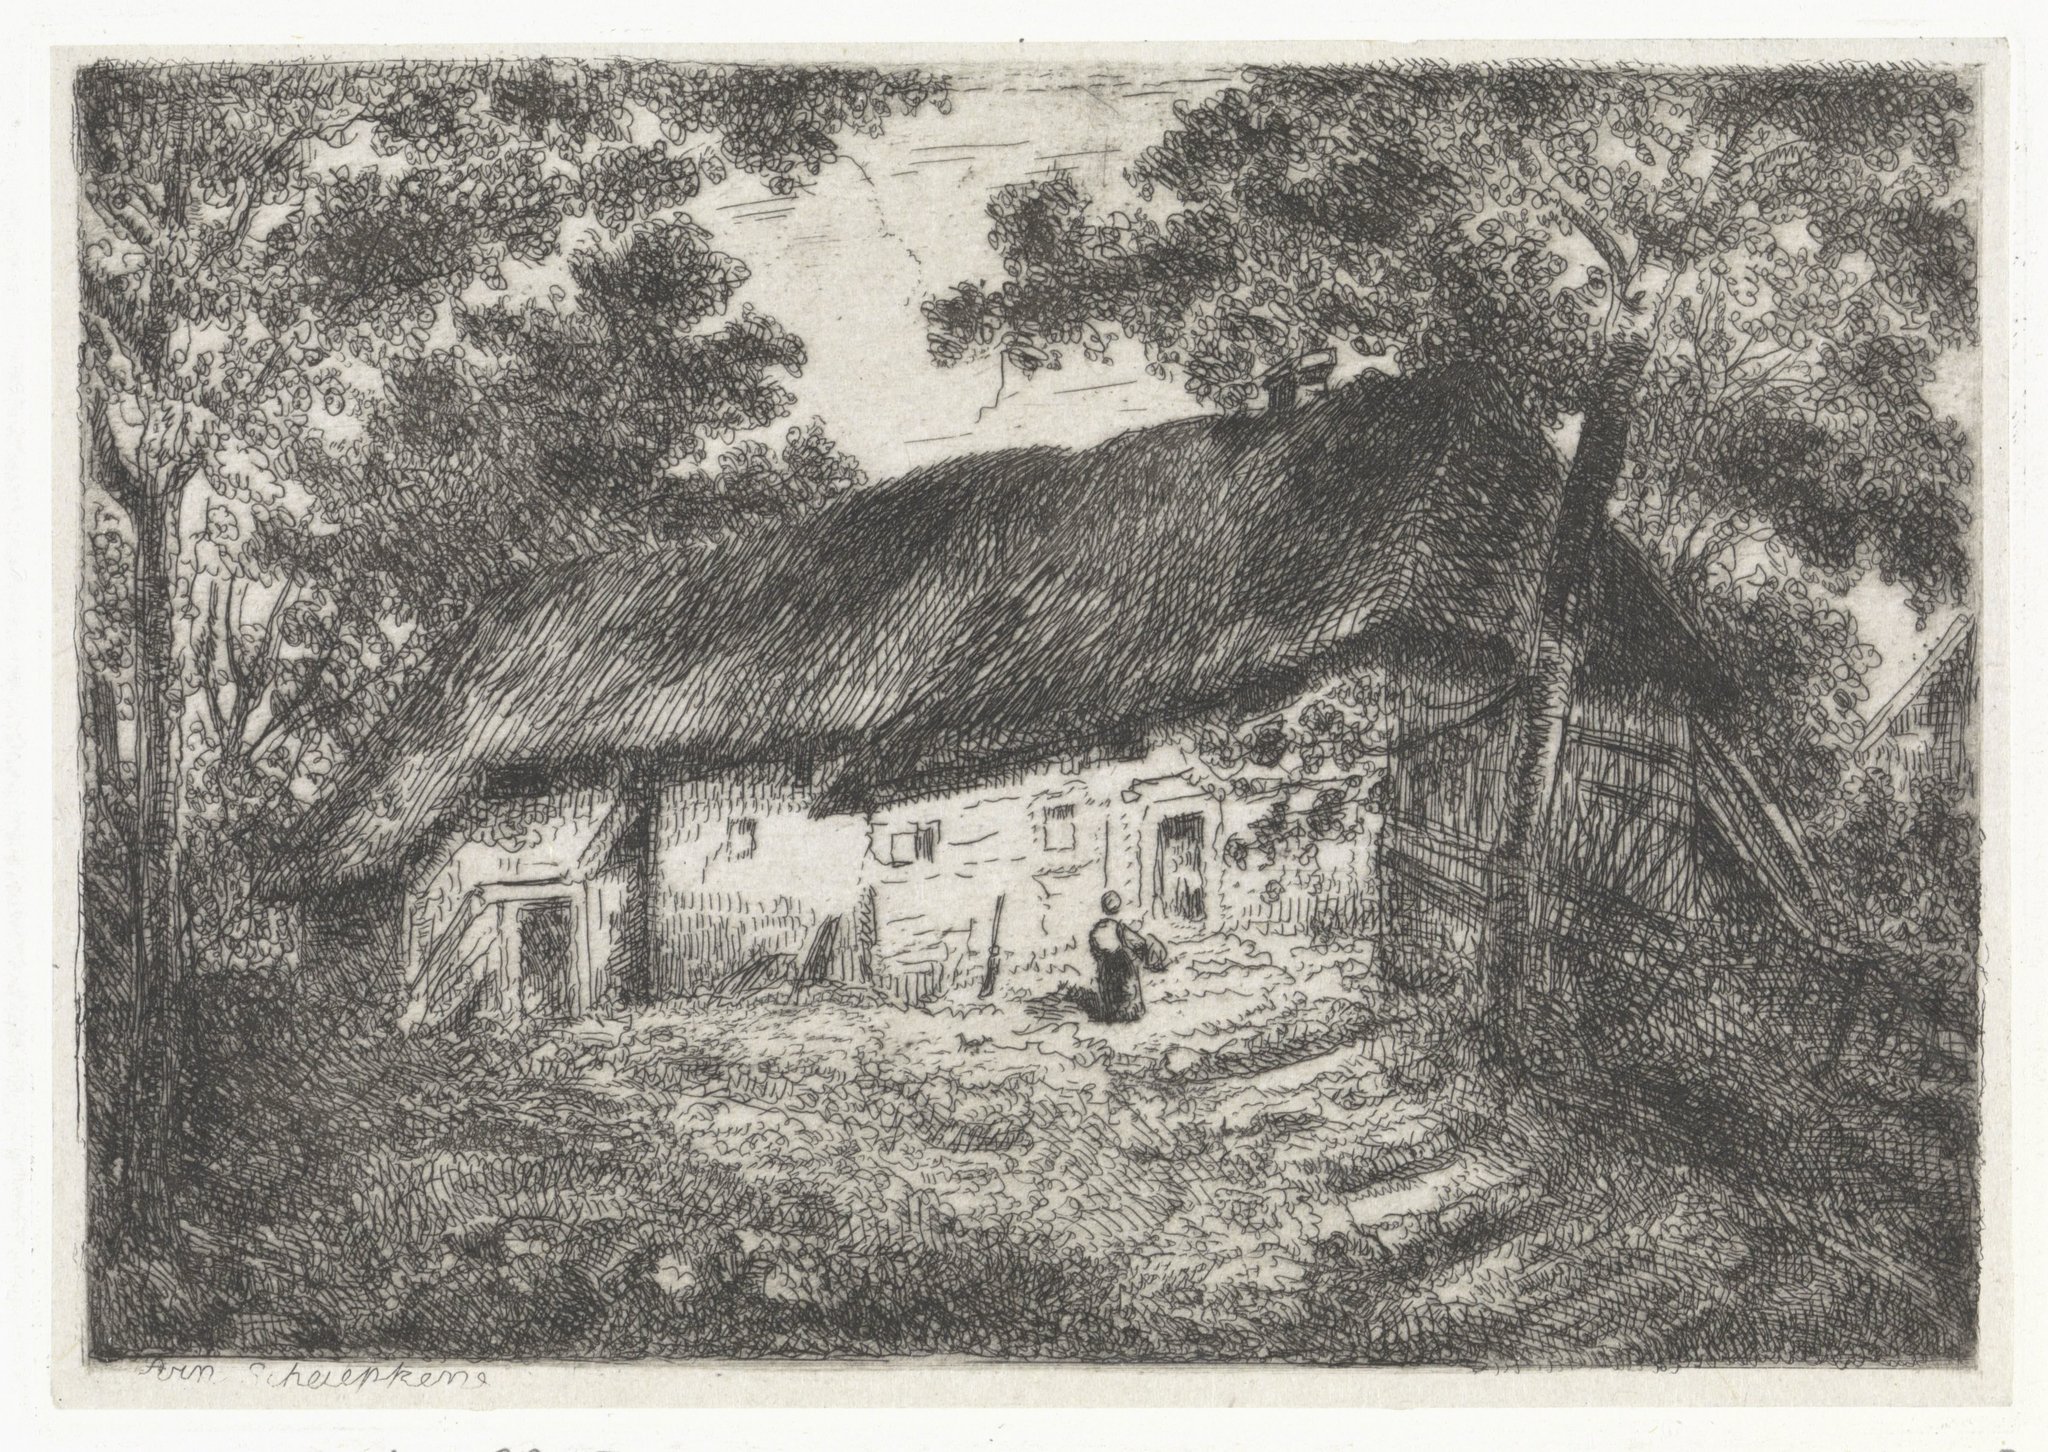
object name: print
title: Lange boerderij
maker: arnoud schaepkens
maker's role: print maker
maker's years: 1816-1904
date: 1831-1888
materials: paper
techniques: drypoint, etching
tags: farm or solitary house in landscape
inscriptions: collector's mark: Lugt 2228